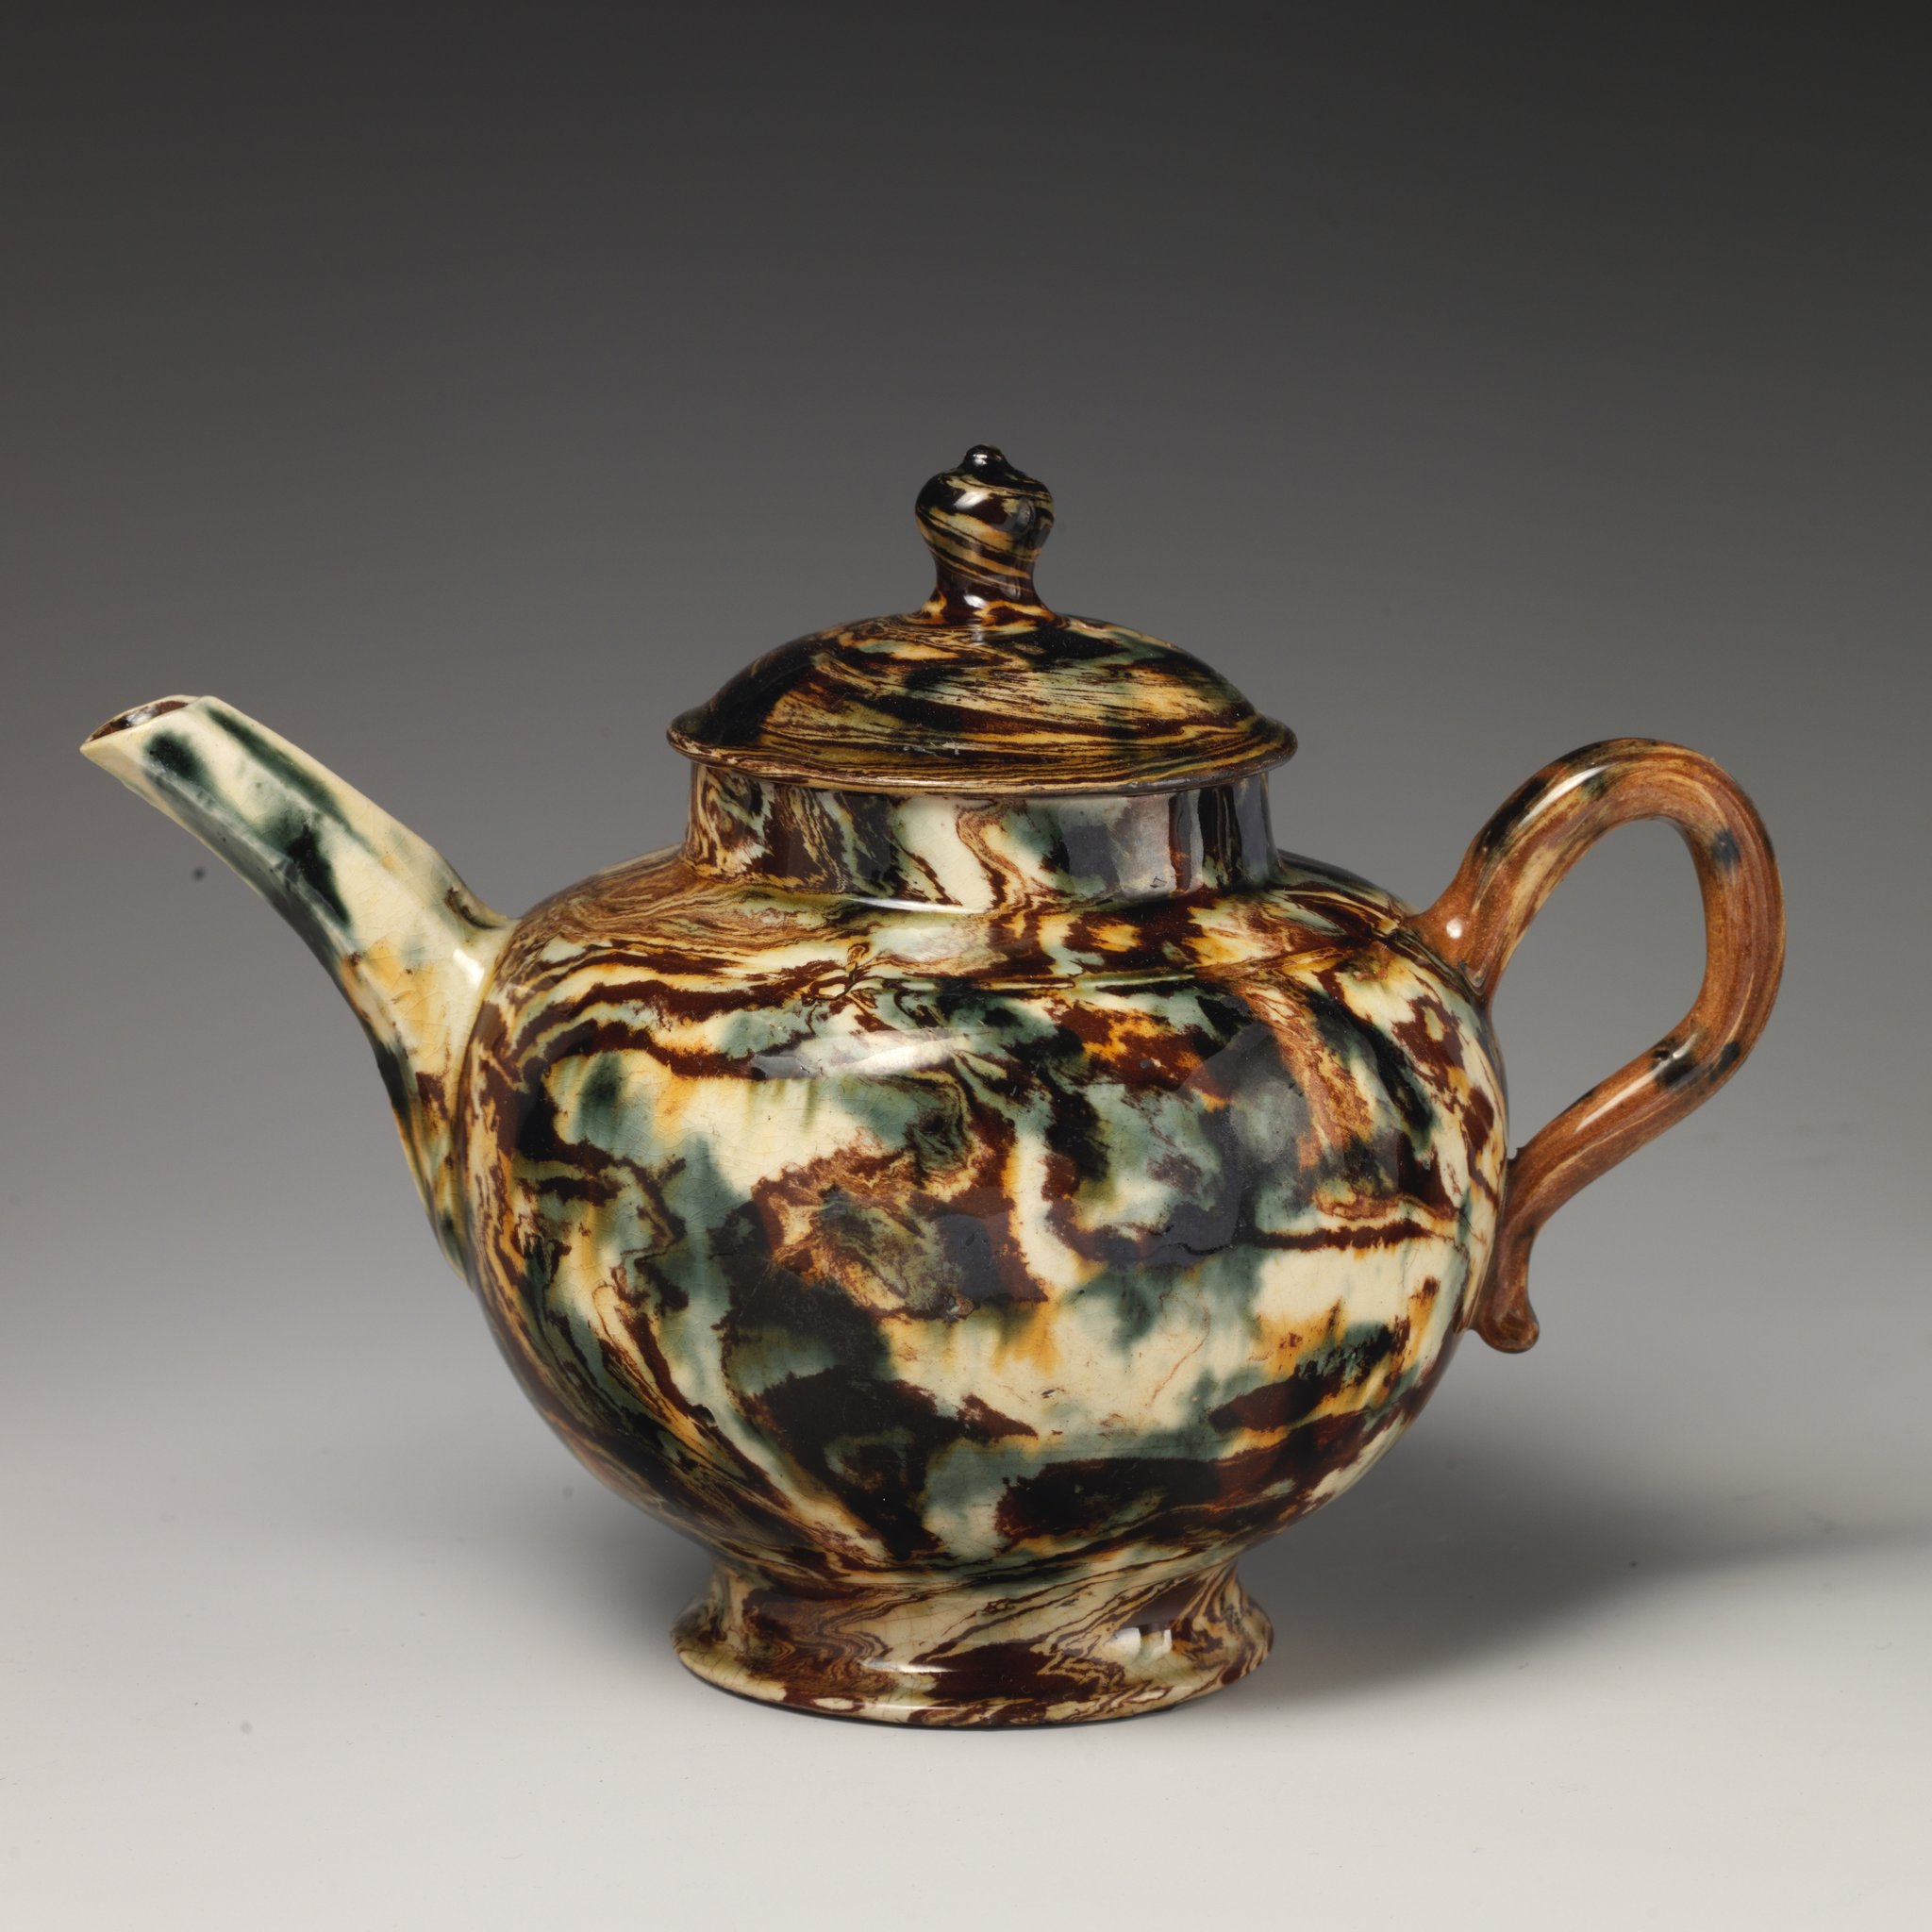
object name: teapot with cover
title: Teapot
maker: whieldon type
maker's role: maker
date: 1750-1765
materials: shell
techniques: glazing